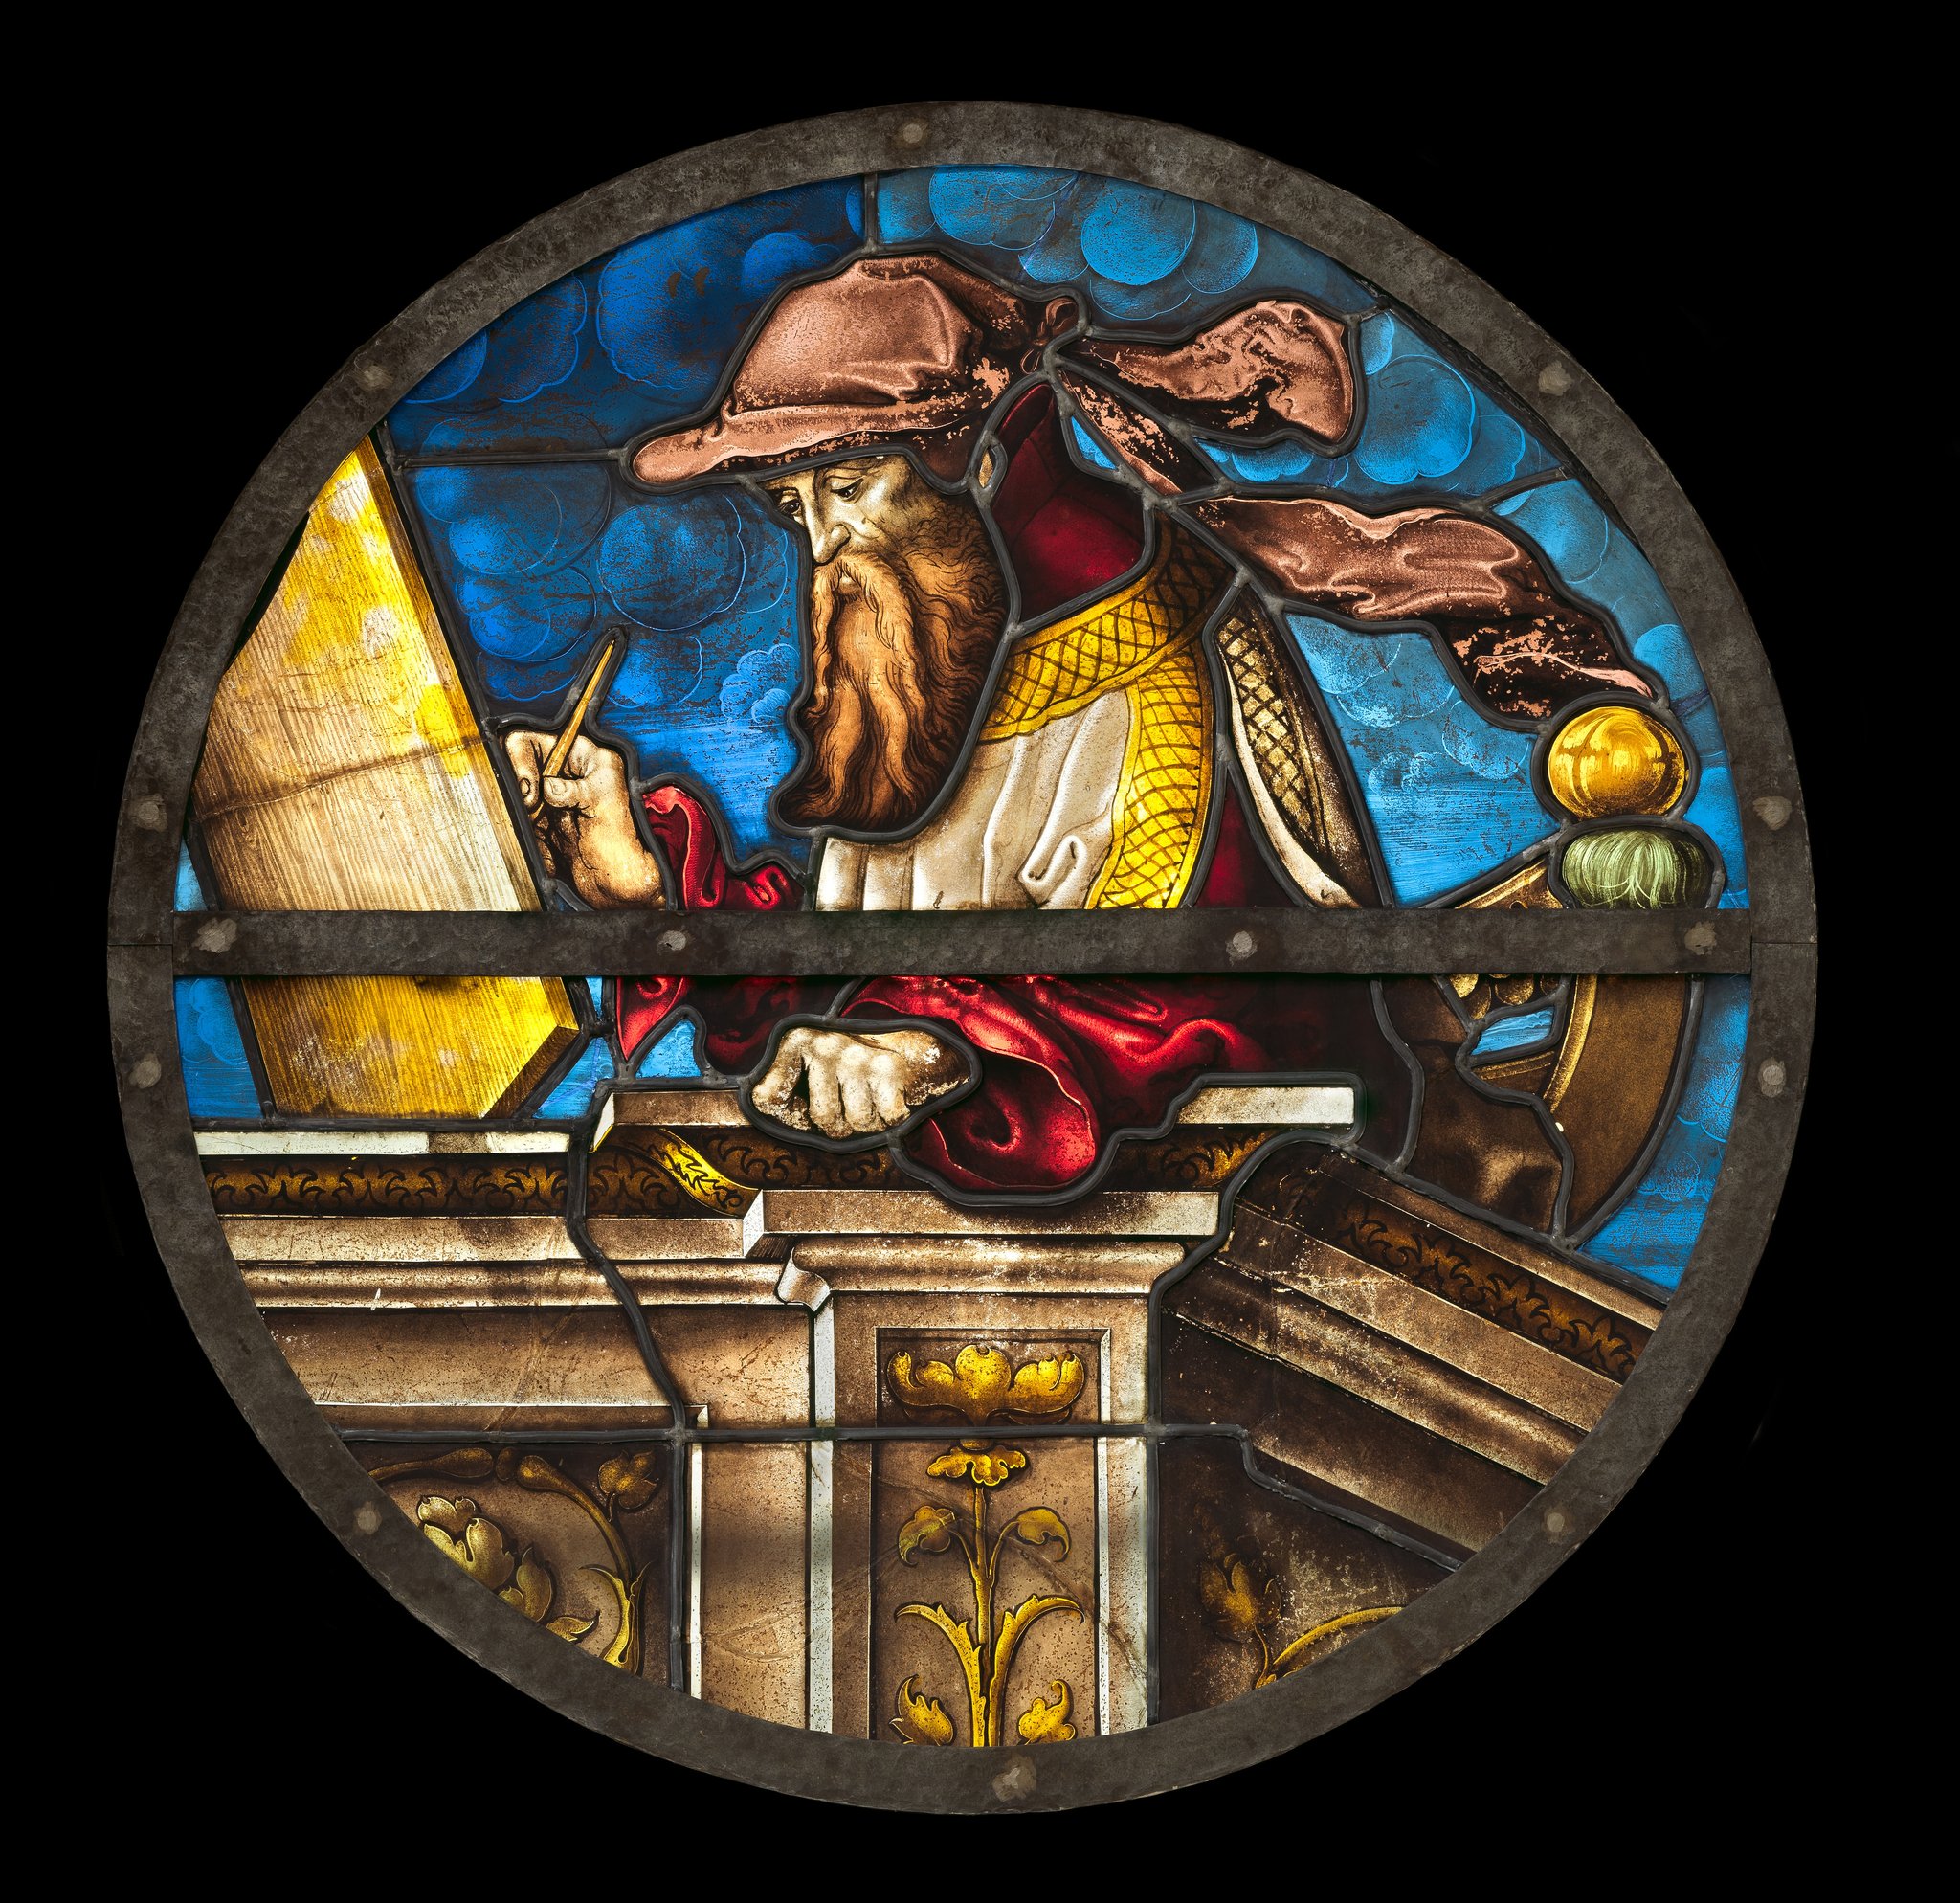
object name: medallion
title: The Prophet Isaiah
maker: valentin bousch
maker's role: artist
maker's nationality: french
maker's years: 1514-1541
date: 1533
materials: glass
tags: men,writing